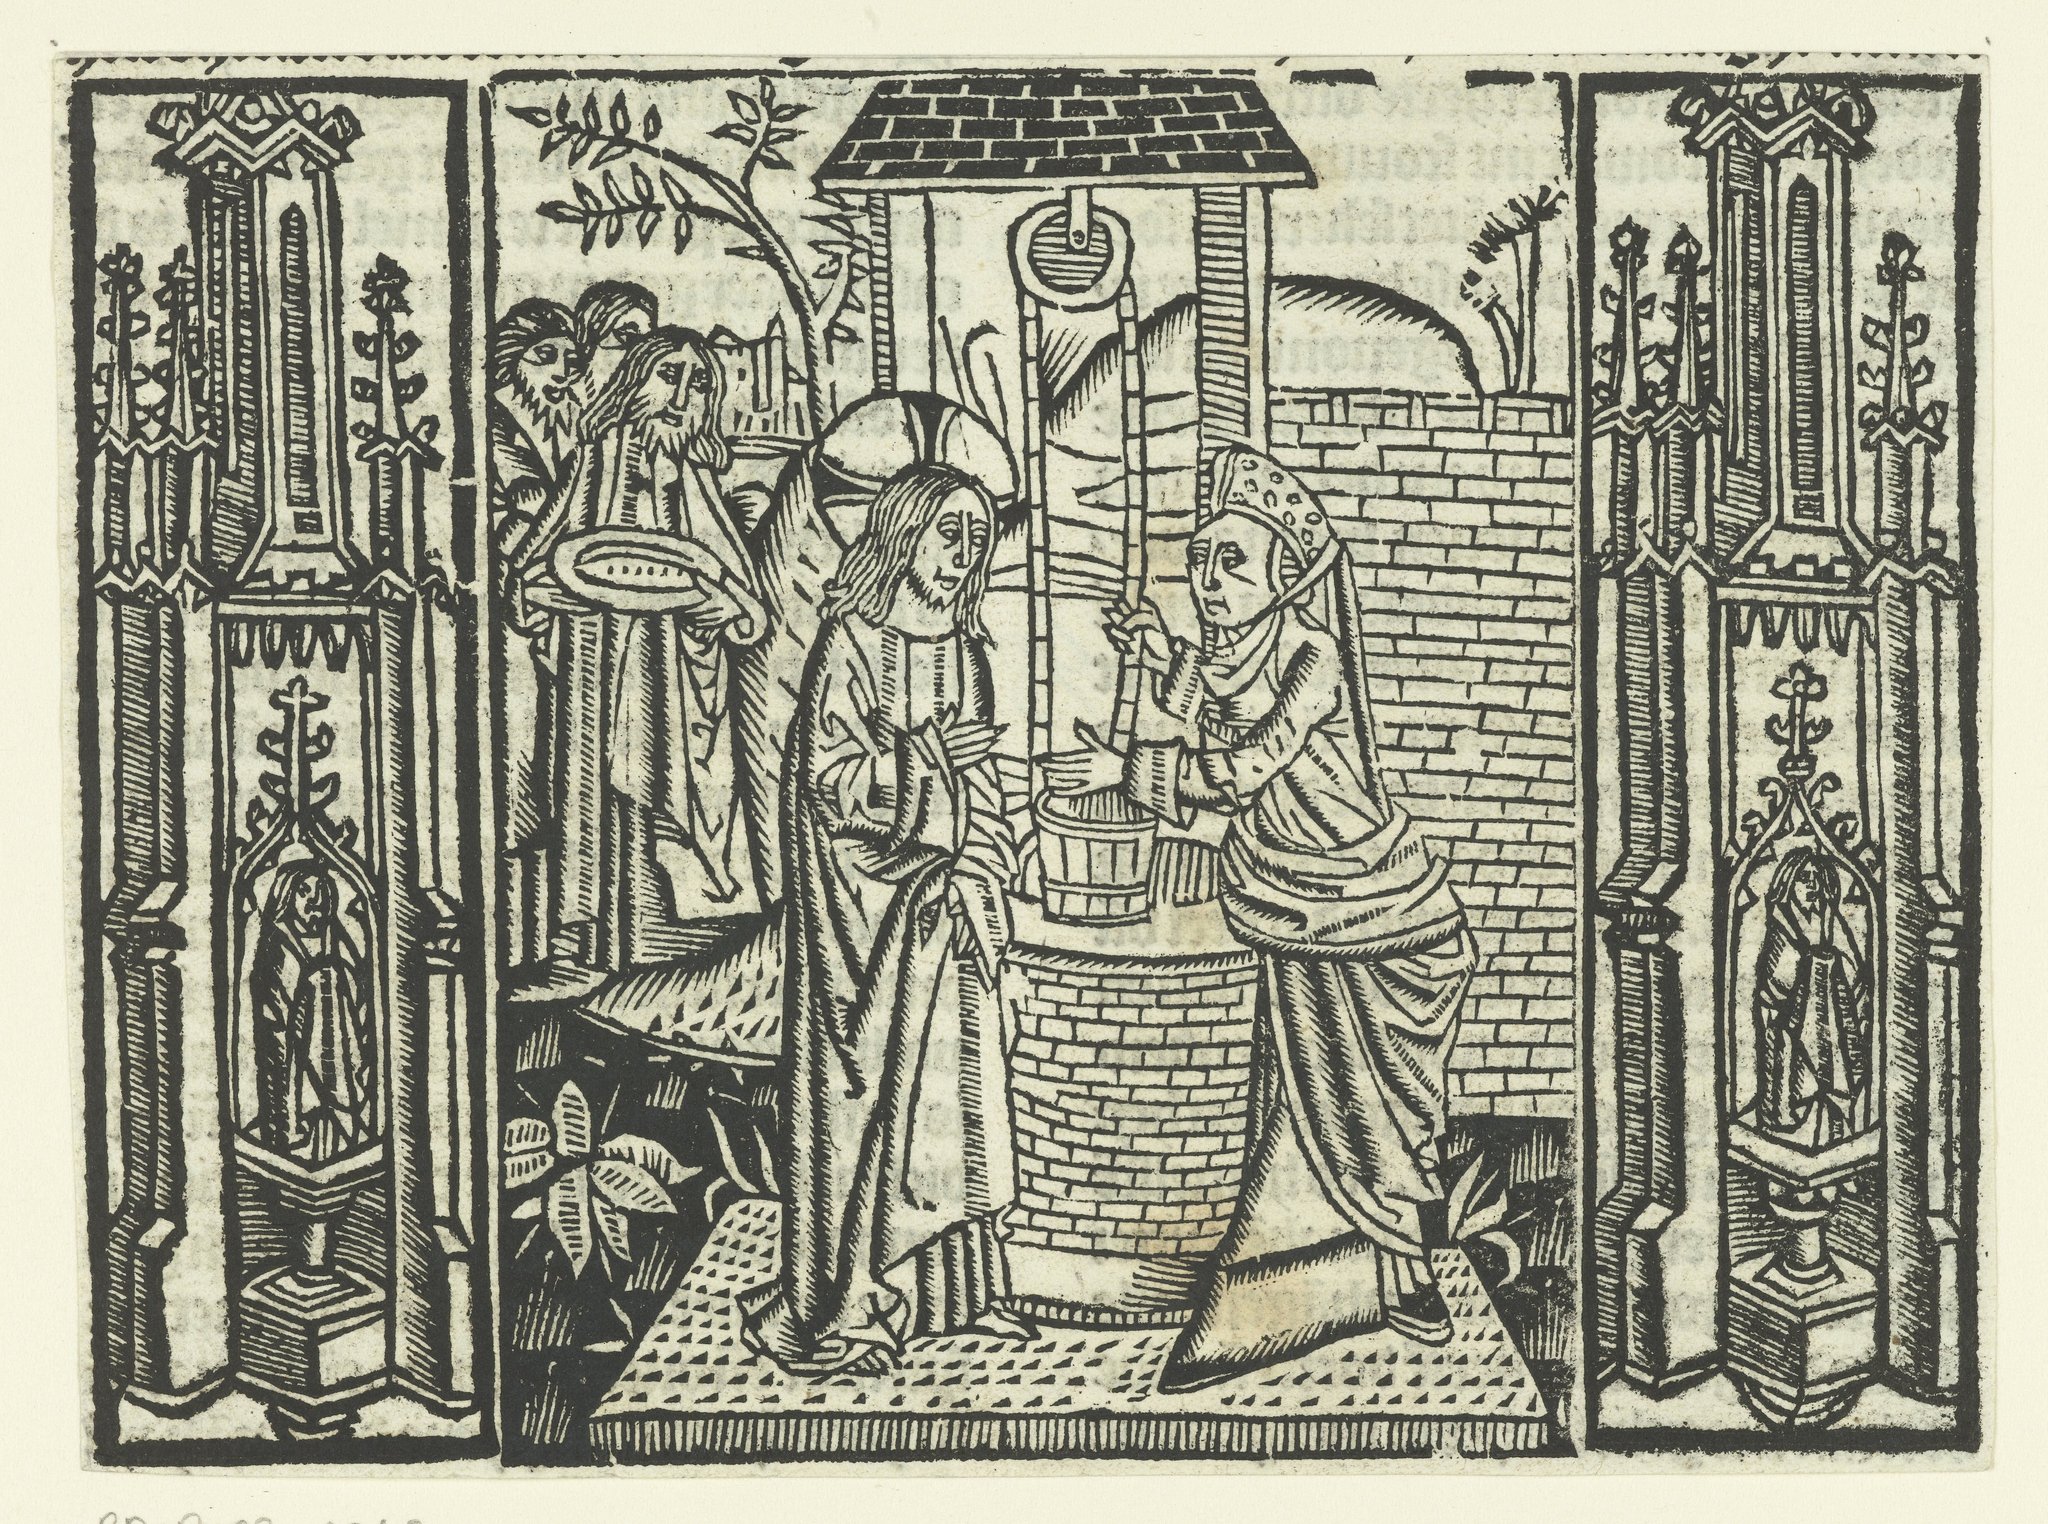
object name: book illustration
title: Christus en de Samaritaanse vrouw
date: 1480-1500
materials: paper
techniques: woodcut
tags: christ and the woman of samaria: sitting at jacob's well he asks her for a drink from her jug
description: Eén blad van 113 uit Ludolphus de Saxonia, "Dit es dleué ons liefs heeren ihesu christi". Anonieme Nederlandse vertaling. Uitgegeven door Henrick Eckert van Homberch te Antwerpen in 1503. Botke, K. Deze 113 houtsneden, die meestal reeds in vroege Nederlandse boeken gebruikt zijn, worden toegeschreven aan de tweede Meester van Delft, de Meester van de Delbecq-Schreiber-passie en de Meester van de Virgo inter Virgines. In Conway (1884) en in "De gulden passer"(1951) zijn ook eerdere versies opgenomen. Botke, K.